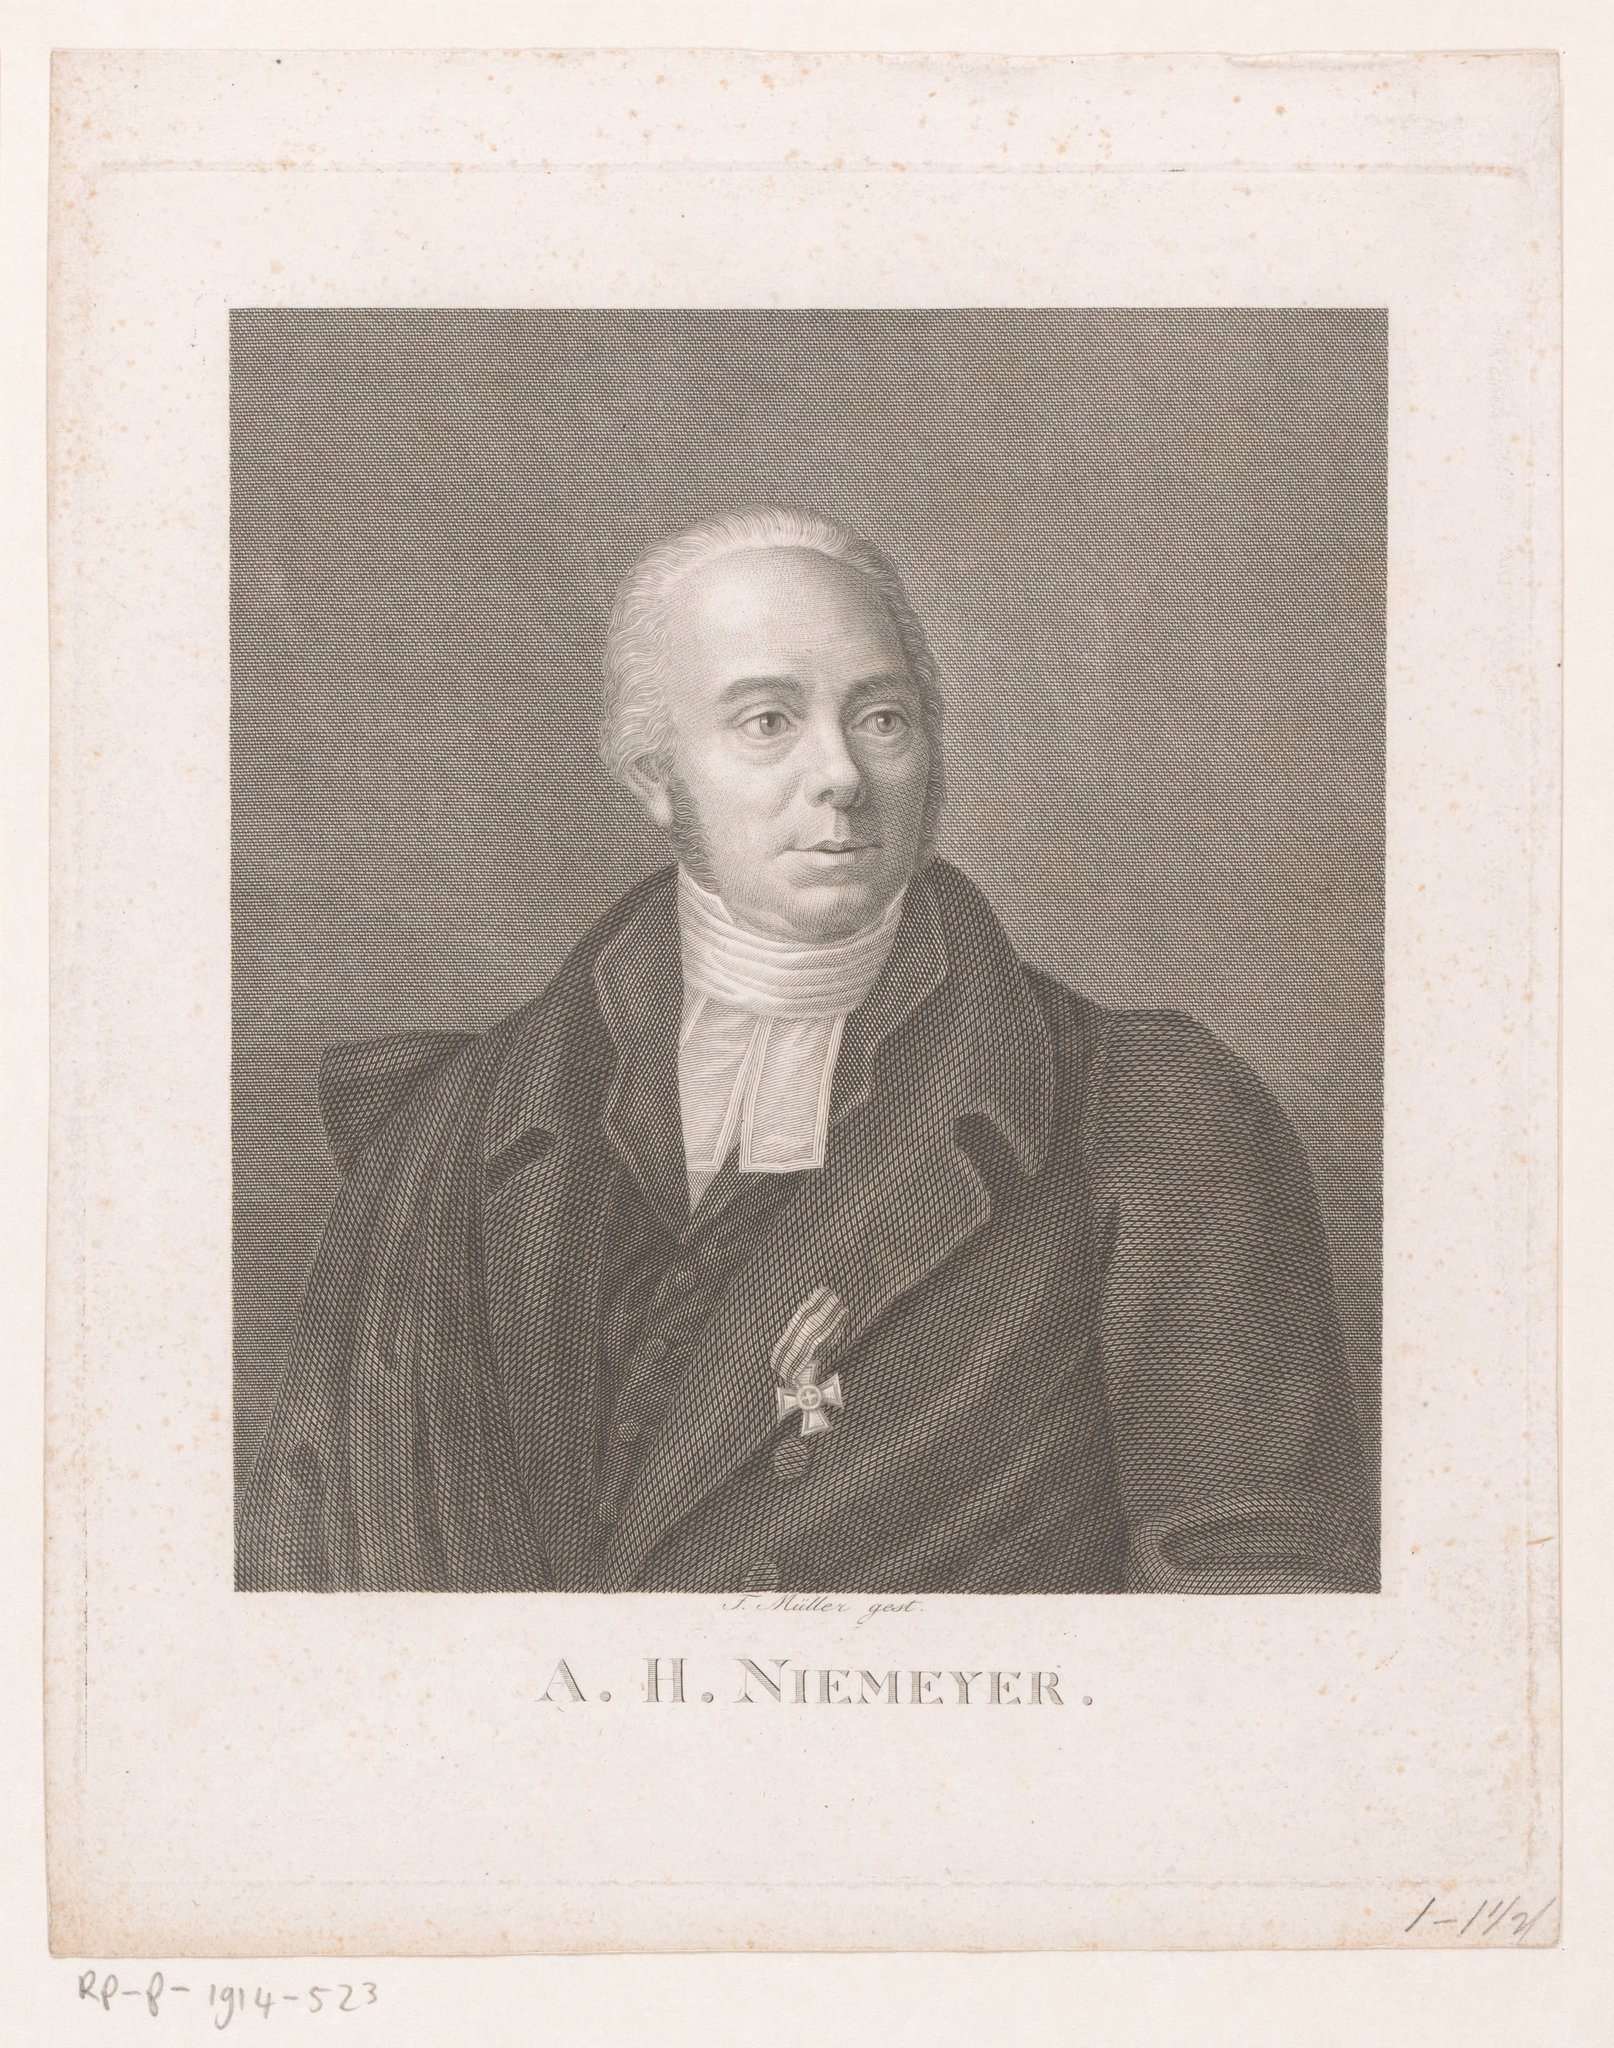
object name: print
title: Portret van August Hermann Niemeyer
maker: johann friedrich wilhelm müller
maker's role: draughtsman, print maker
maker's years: 1782-1816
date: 1792-1816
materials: paper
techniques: engraving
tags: historical persons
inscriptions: collector's mark: Lugt 2228